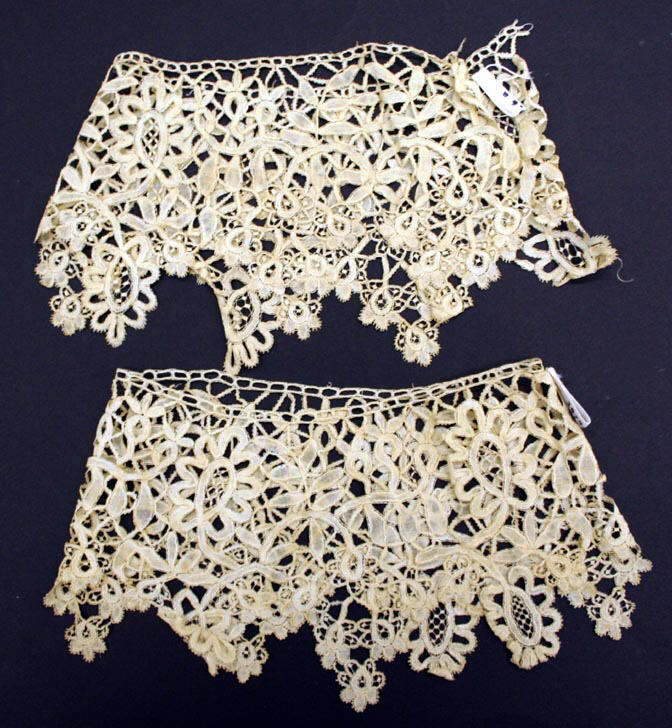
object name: cuff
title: Cuffs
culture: british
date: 1801-1900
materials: linen